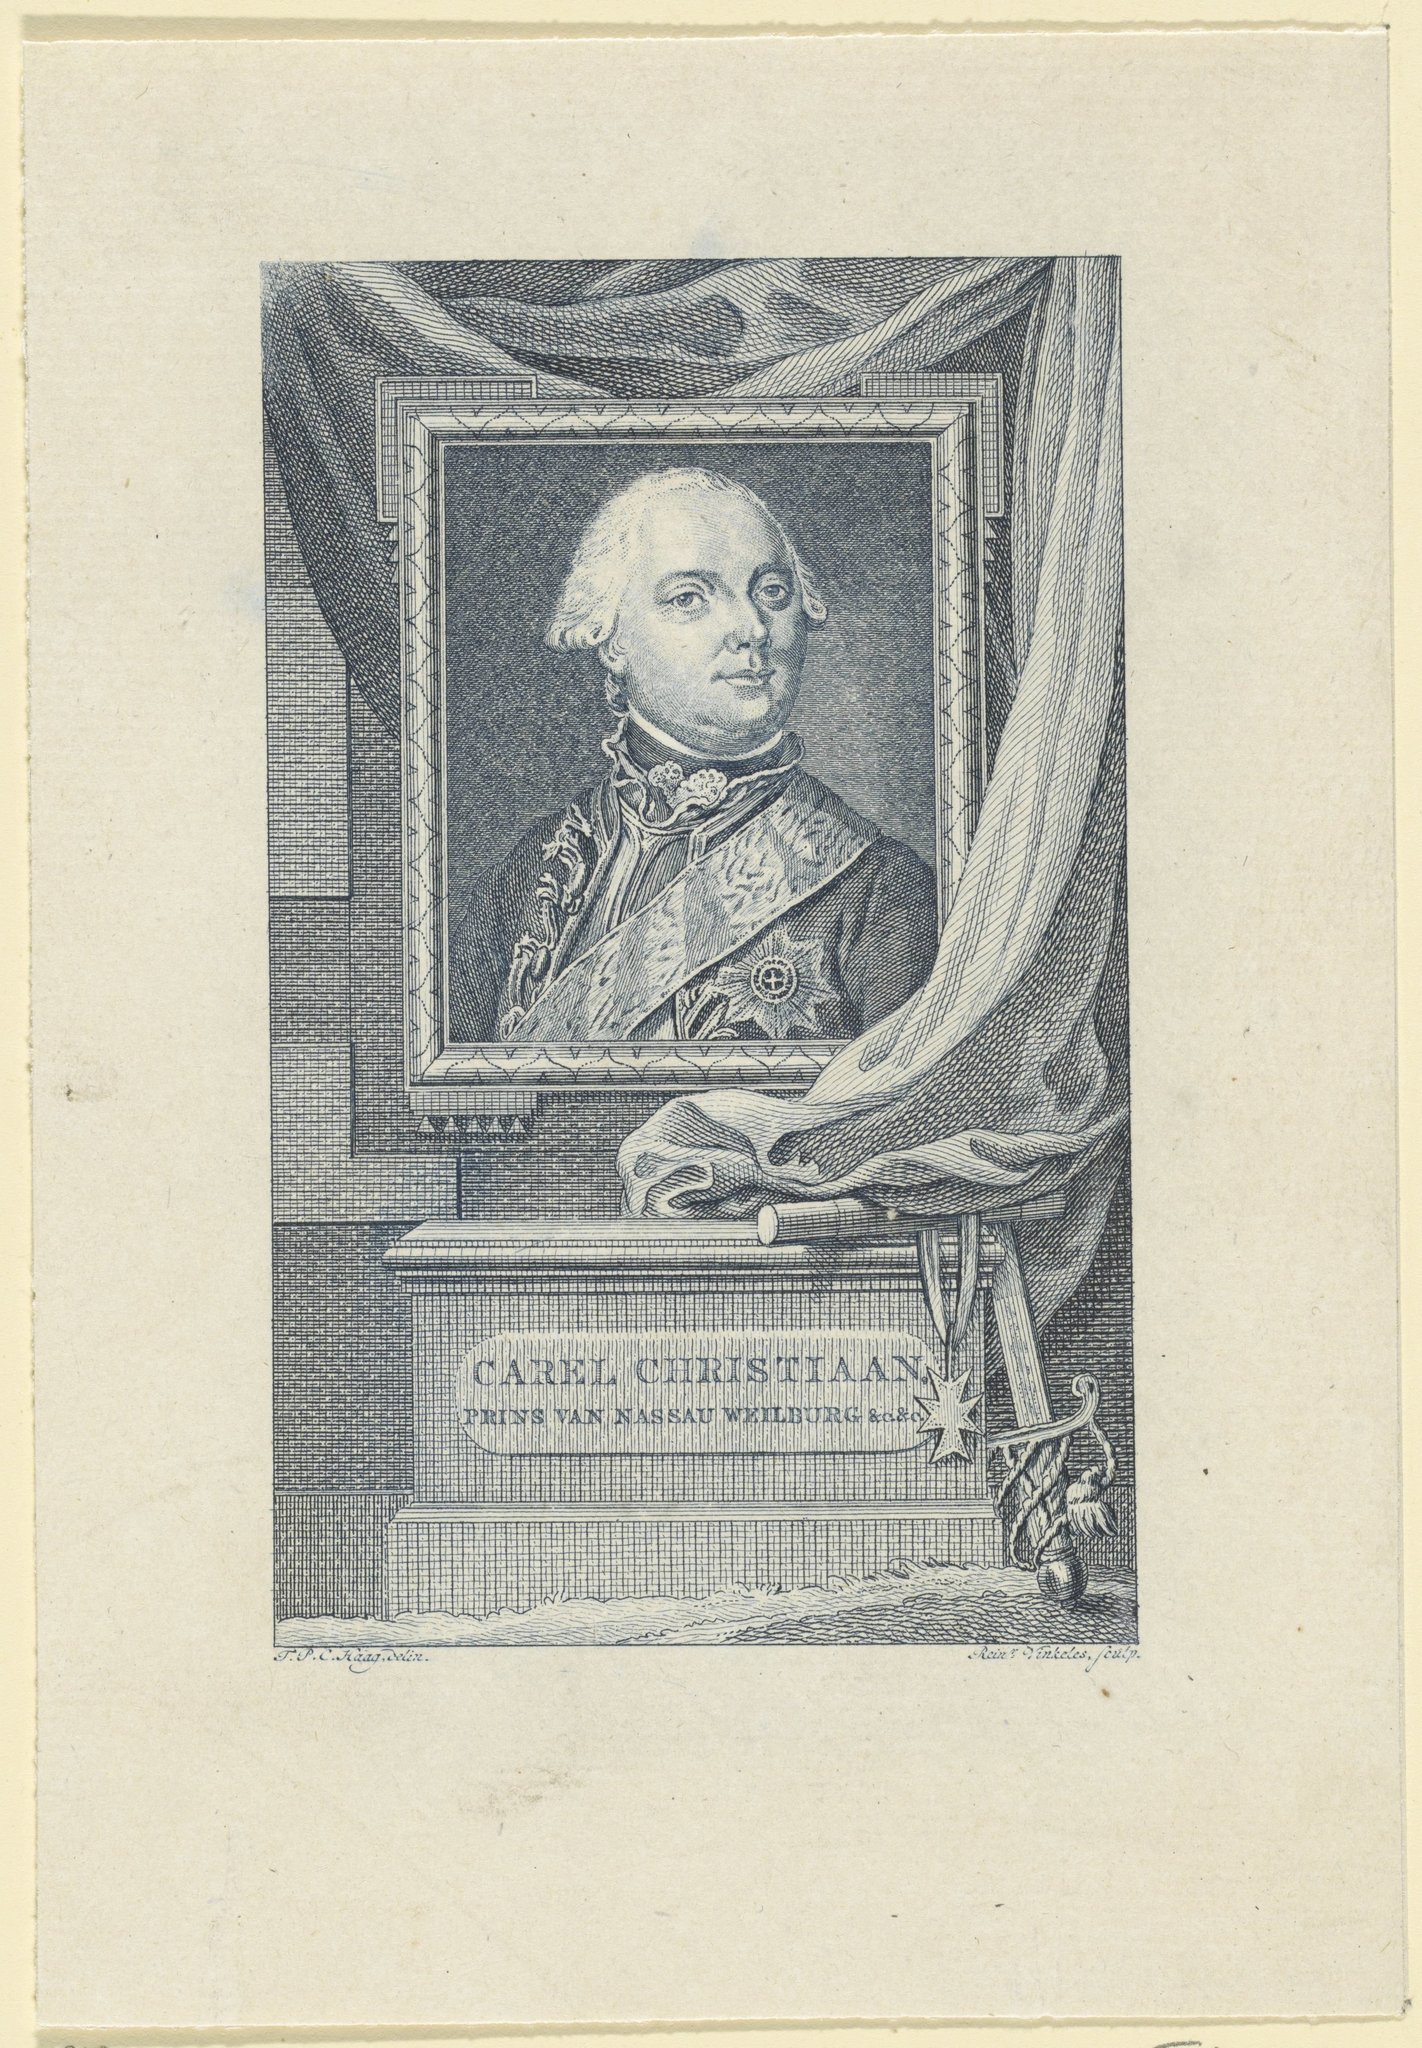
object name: print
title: Portret van Karel Christiaan van Nassau-Weilburg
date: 1762-1816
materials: paper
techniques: engraving, etching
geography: amsterdam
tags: karel christiaan vorst van nassau-weilburg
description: Portret van Karel Christiaan in een geornamenteerde rechthoek. Daar omheen een aantal allegorische objecten. Op een voetstuk zijn naam en titels.